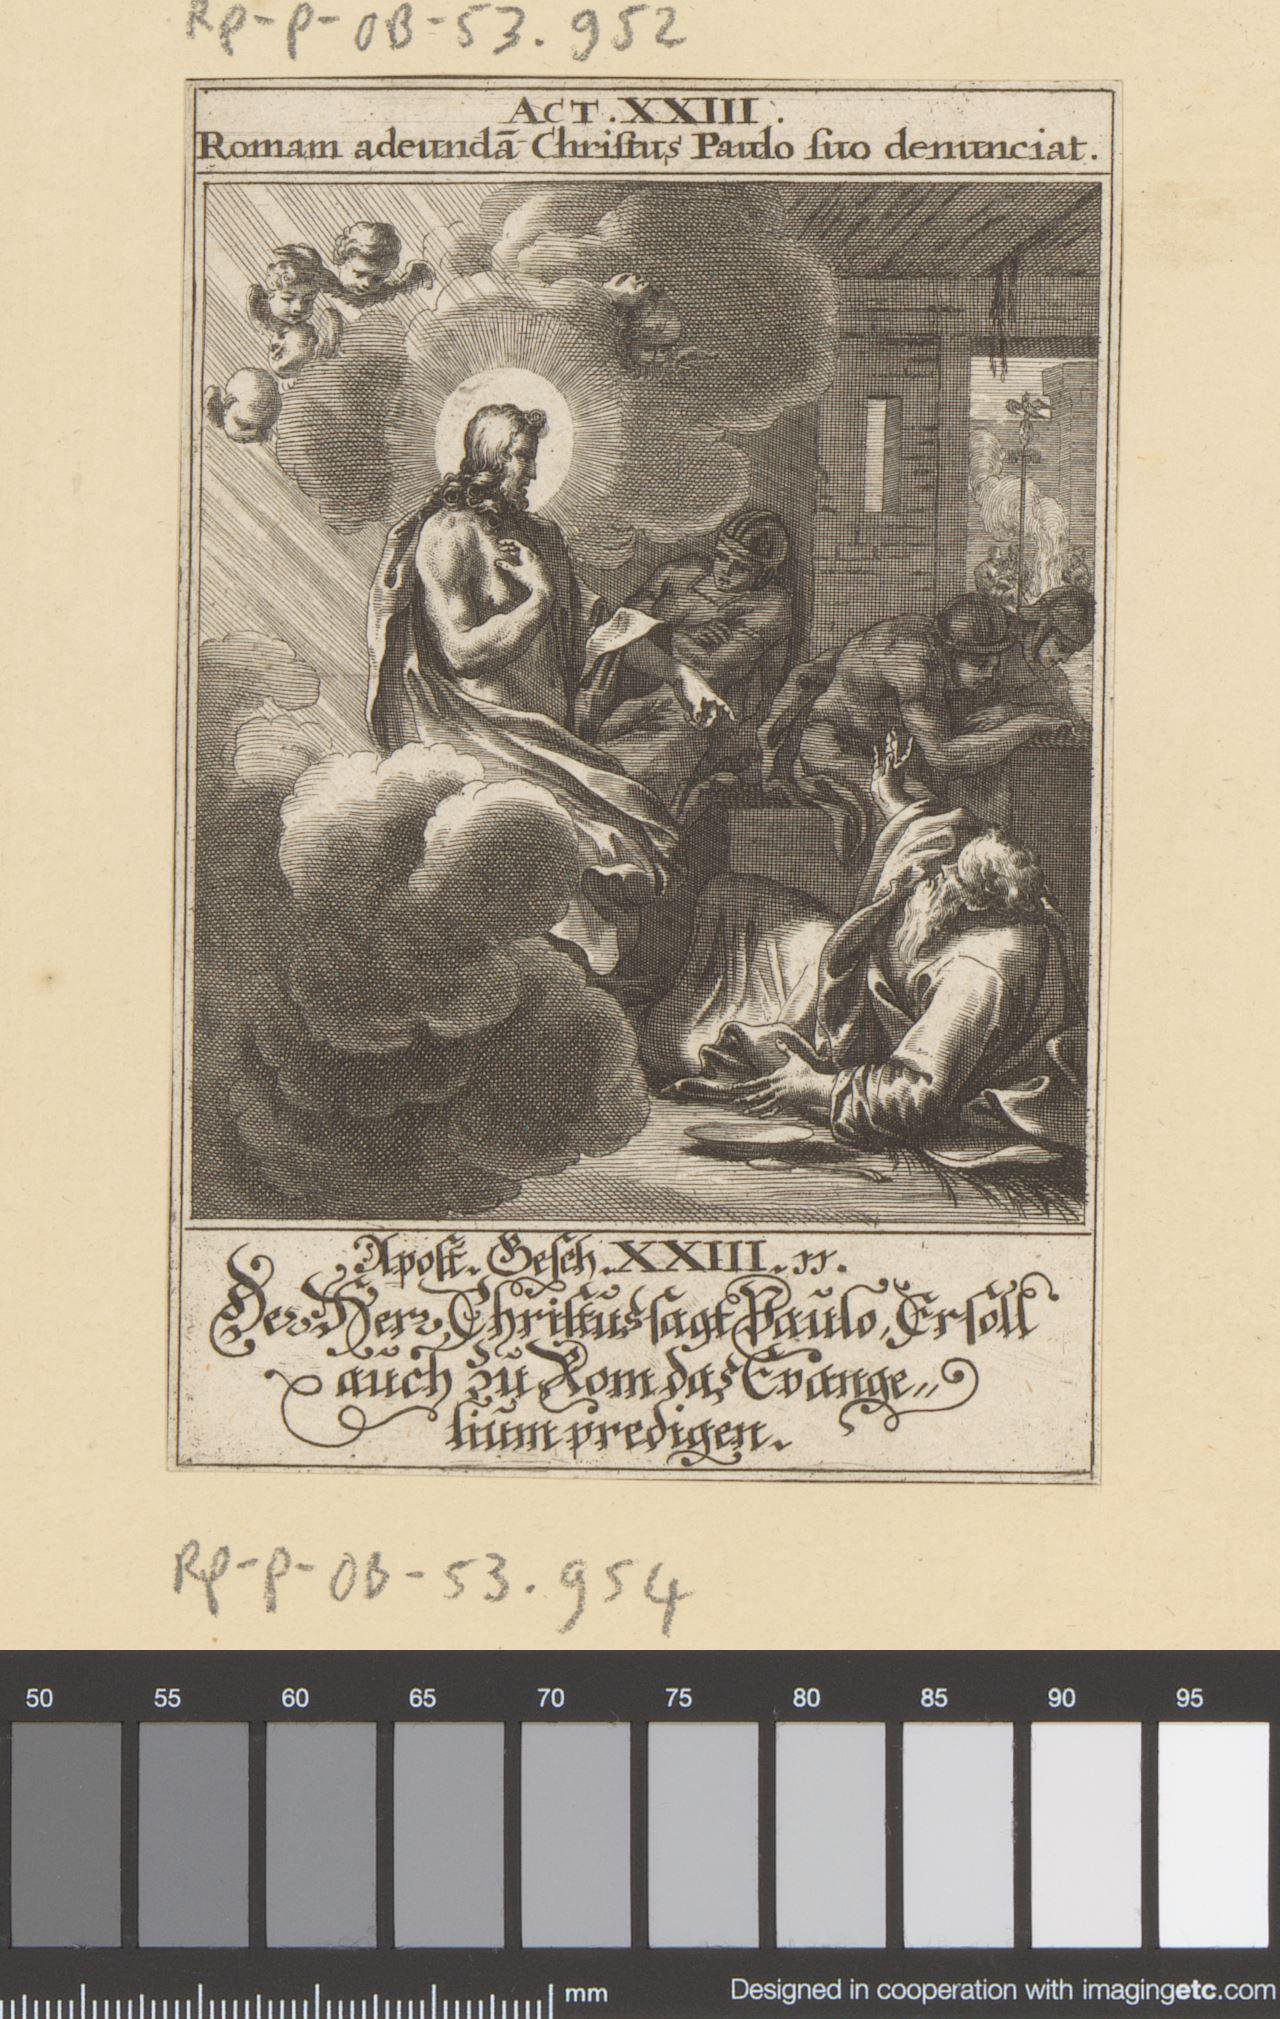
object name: print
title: Christus verschijnt aan Paulus en zegt hem naar Rome te gaan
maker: Anonymous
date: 1697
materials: paper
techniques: etching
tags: god (or angel) speaks to paul during the night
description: Prent ook gebruikt in: Biblia ectypa : Bildnussen auss Heiliger Schrifft. Regensburg: Chr. Wiegel, 1697.